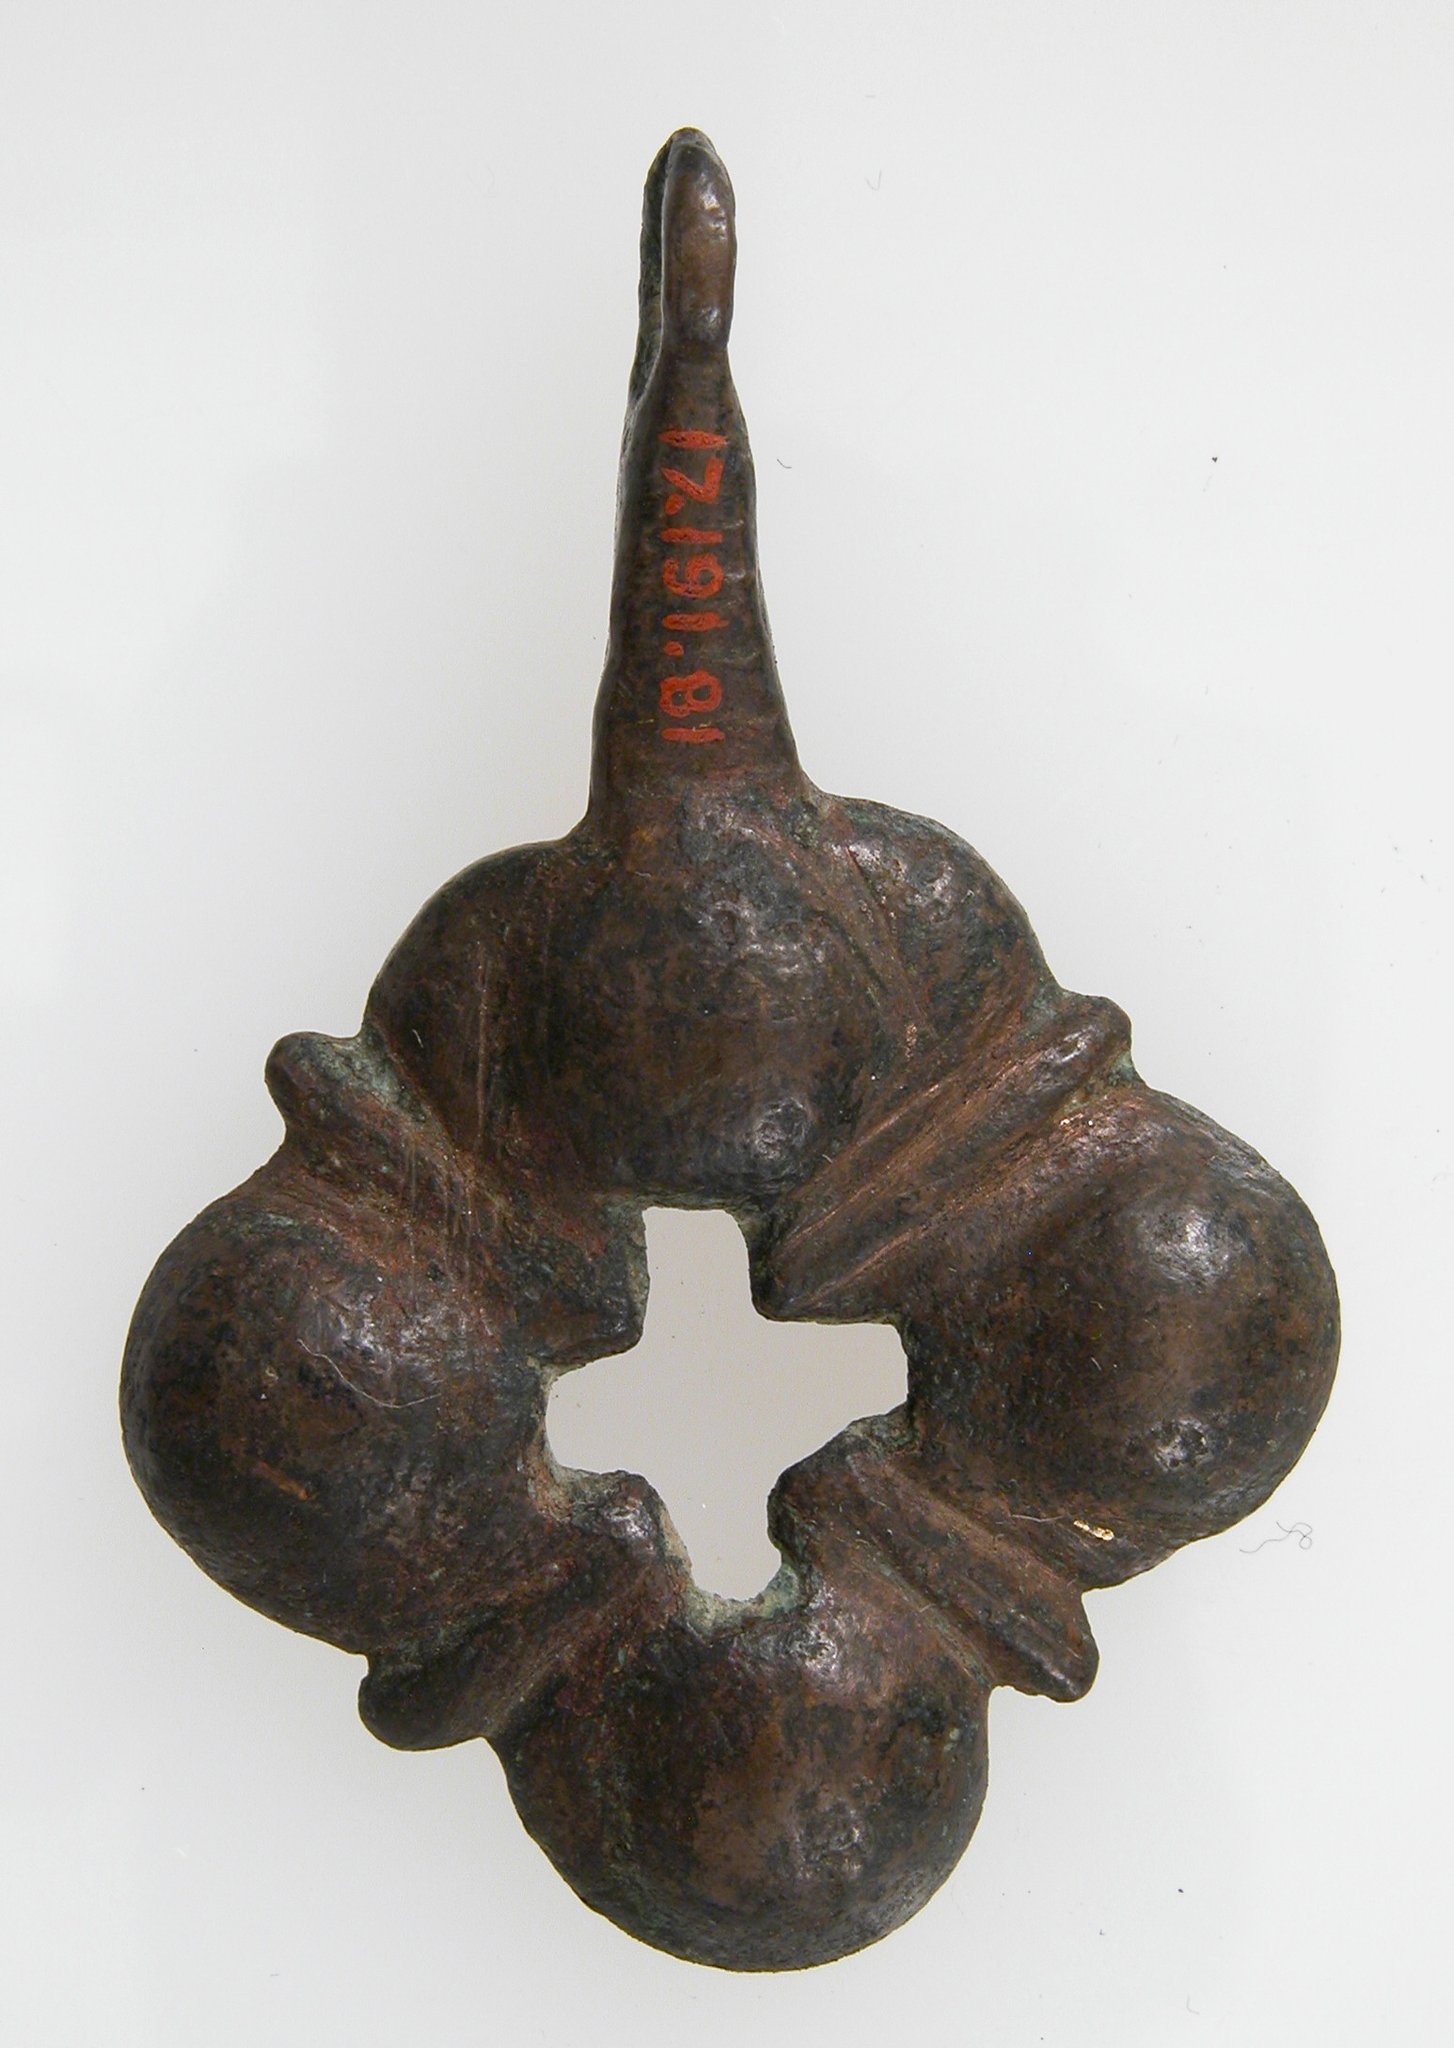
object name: harness ornament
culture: roman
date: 601-700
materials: copper alloy